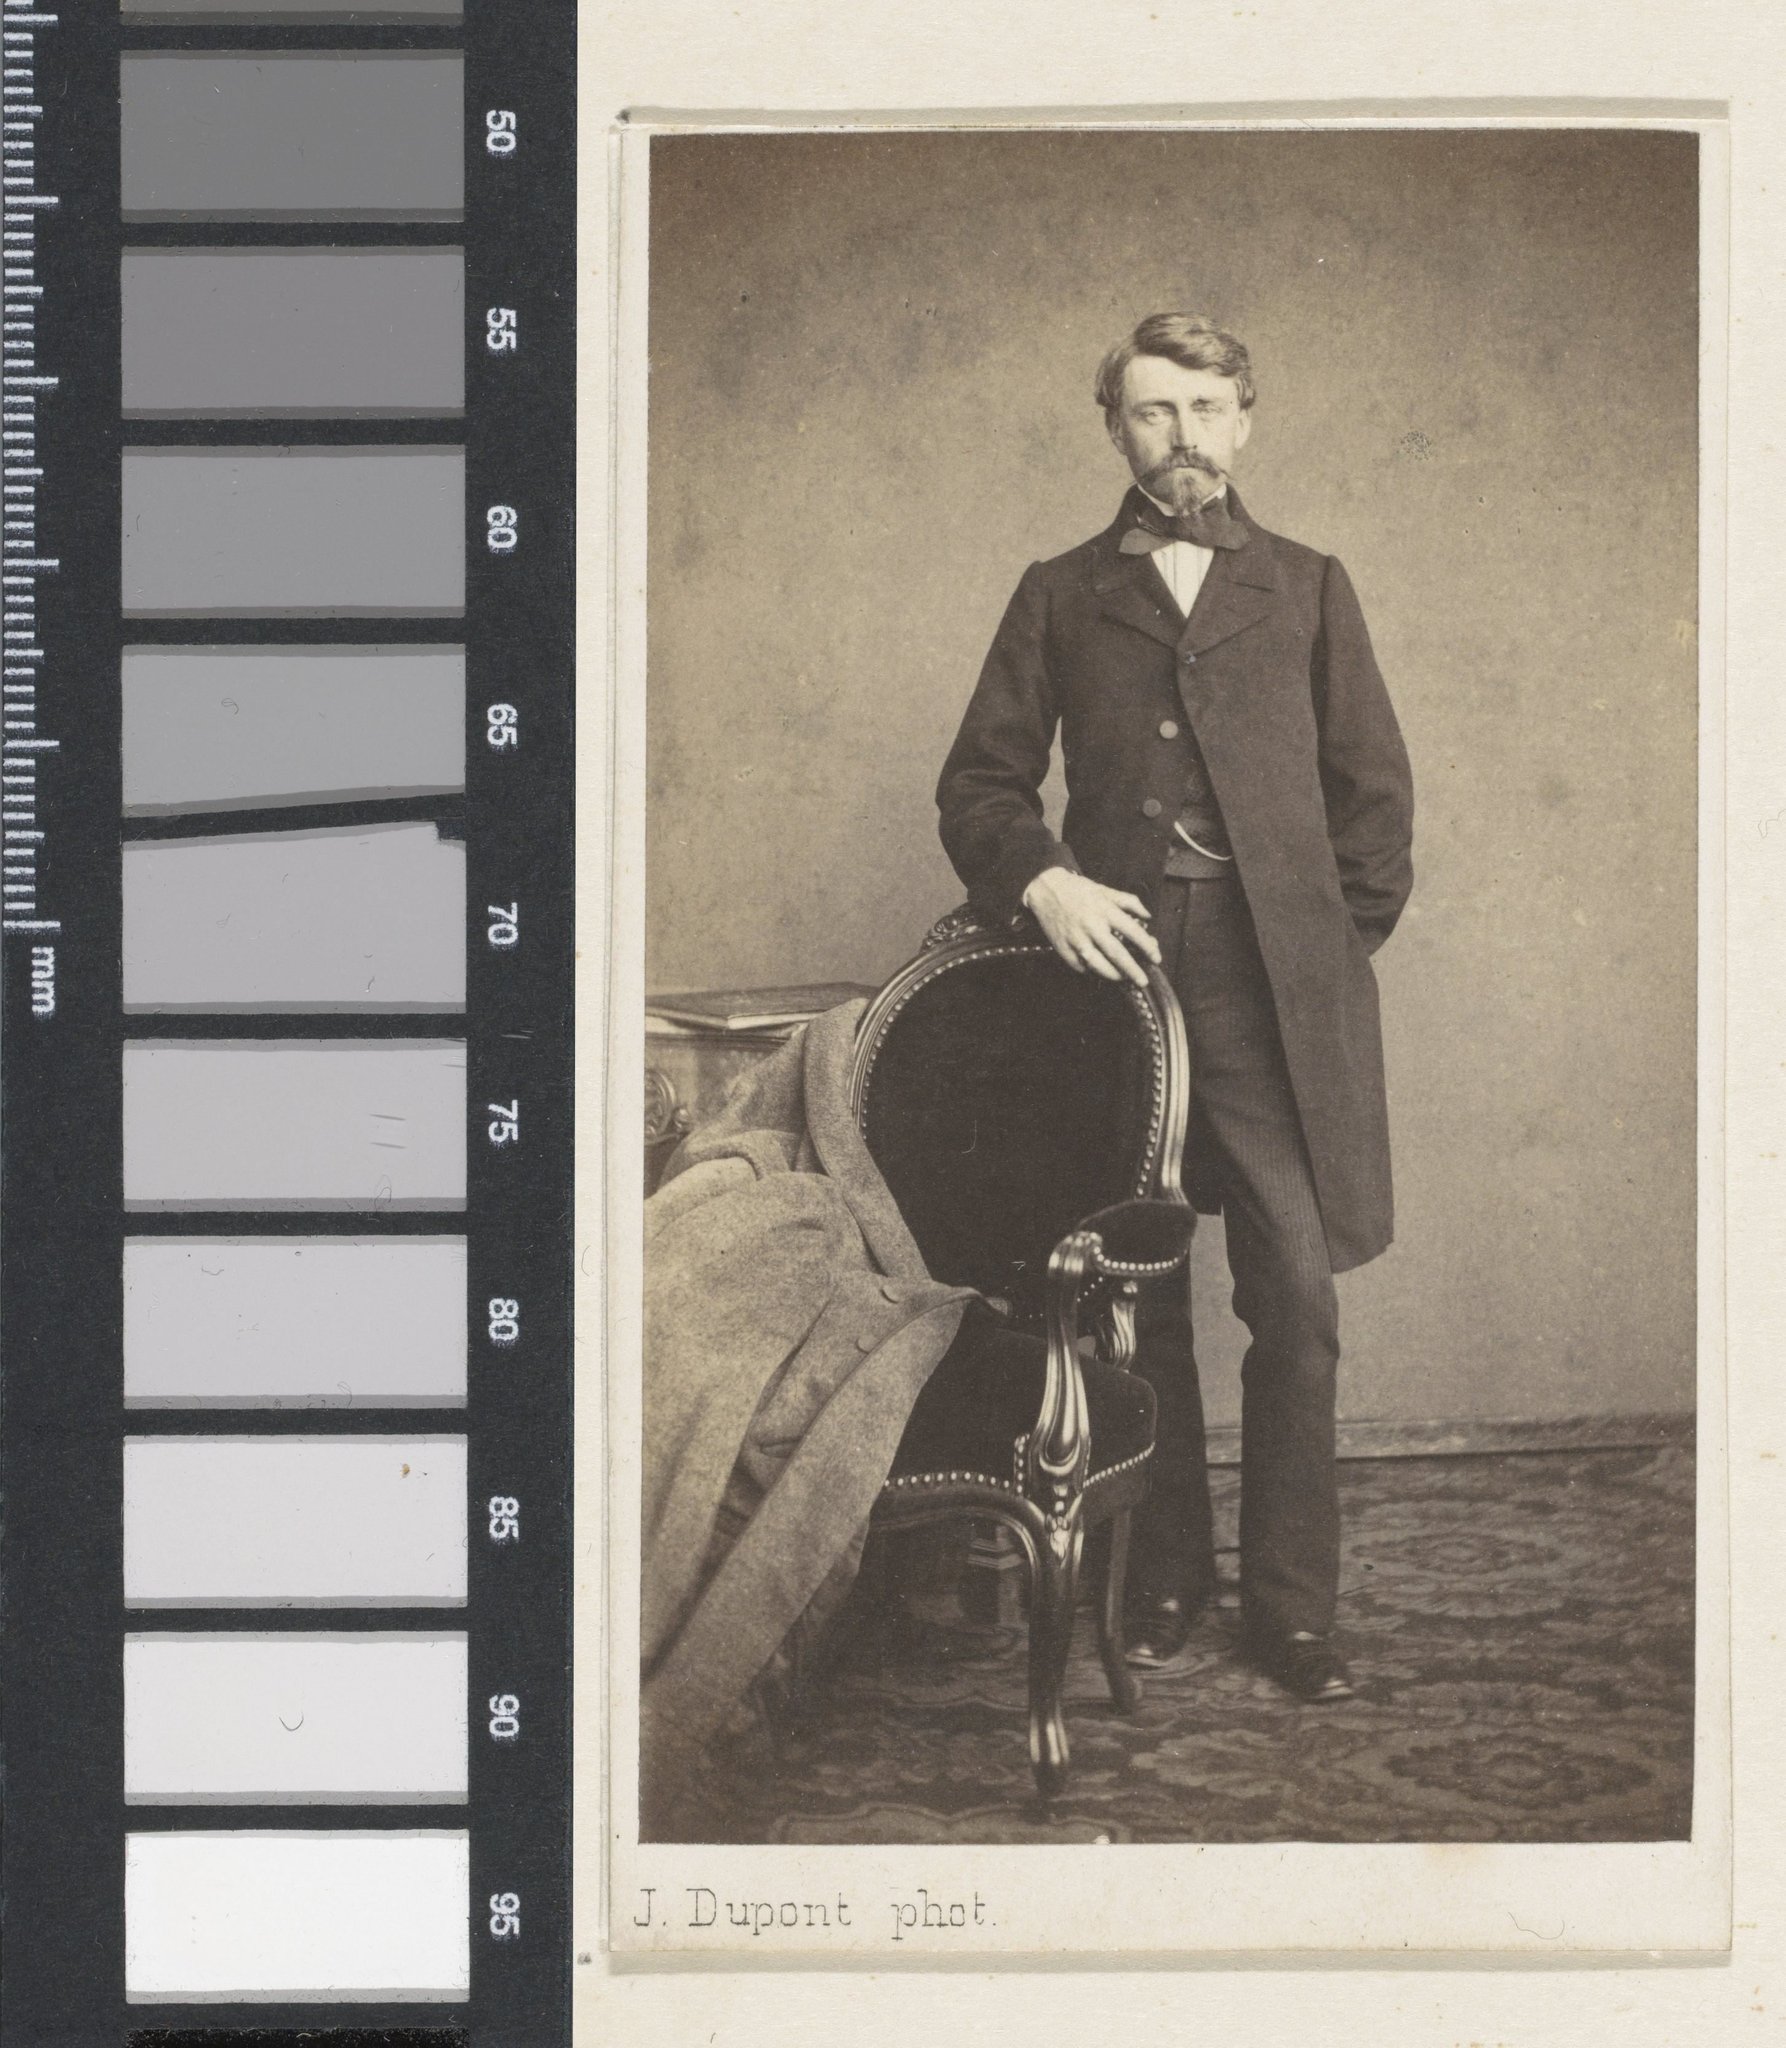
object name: carte de visite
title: Portret van de kunstenaar en burggraaf du Vilain XIIII, ten voeten uit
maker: joseph dupont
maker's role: fotograaf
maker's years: 1818-1901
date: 1861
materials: cardboard, paper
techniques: albumen print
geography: antwerp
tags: artist, historical persons, portrait, self-portrait of artist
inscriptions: inscription: ‘Etablissement Photographique/ DE/ J. DUPONT/ Place de Meir, 32,/ ANVERS./ Maison fondée en 1853’